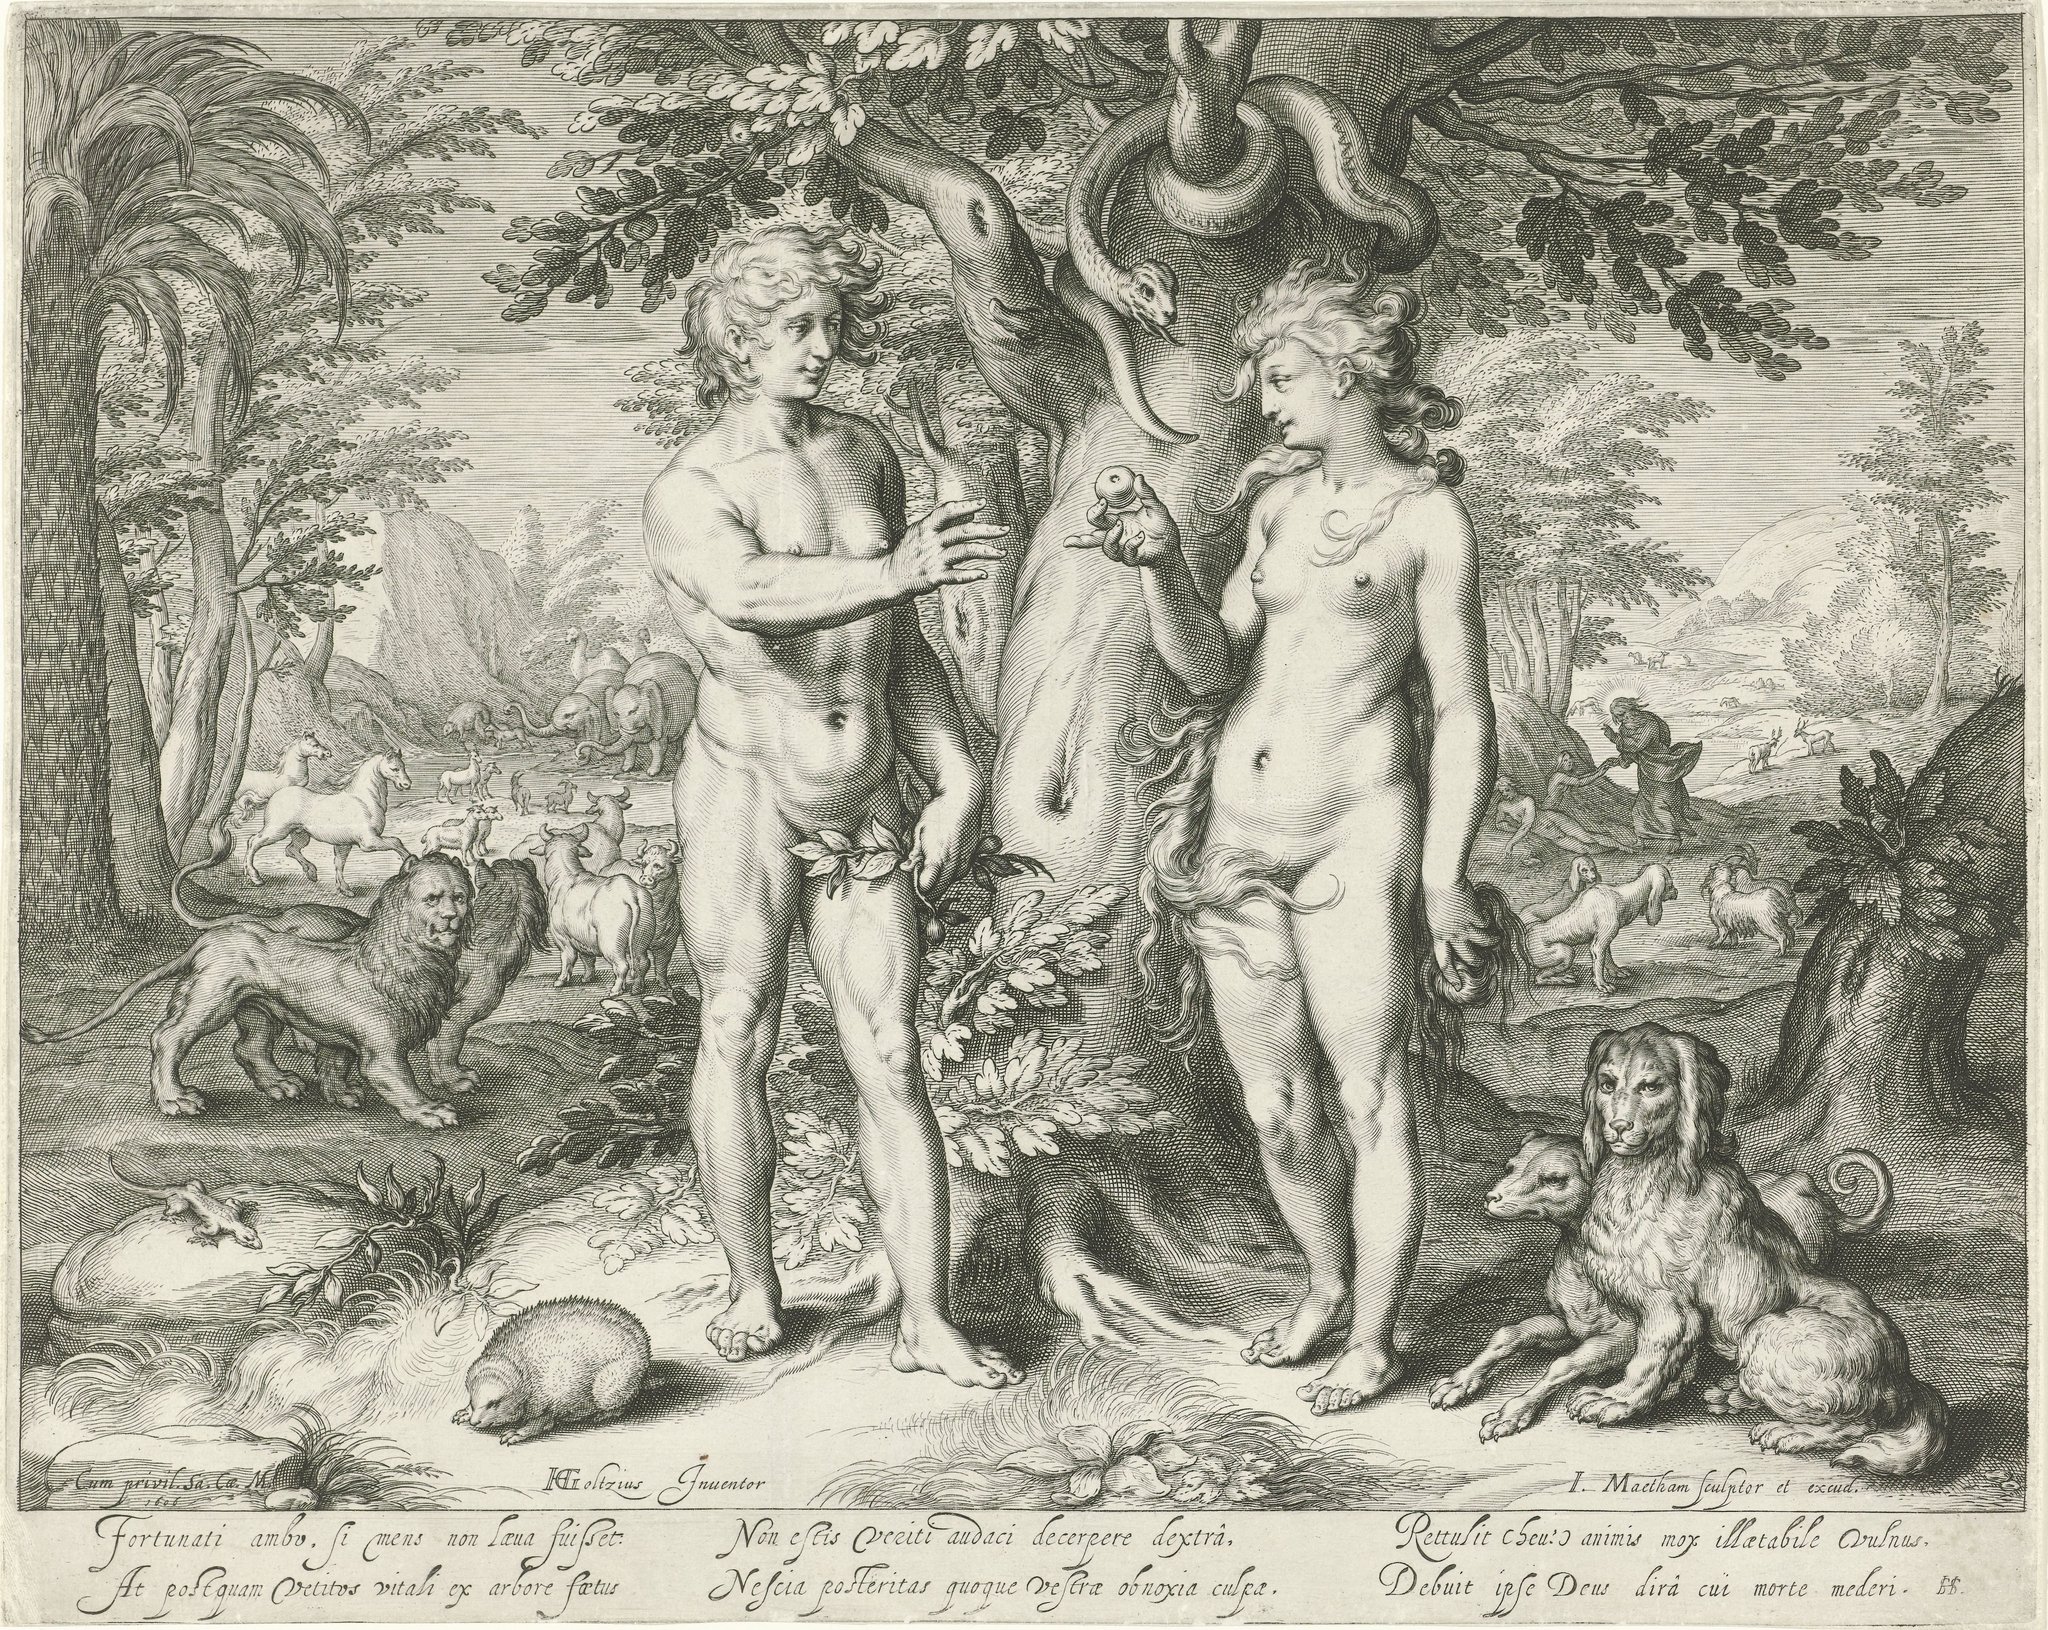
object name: print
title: Adam en Eva in het paradijs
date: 1606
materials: paper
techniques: engraving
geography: haarlem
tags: adam and eve in paradise (before the fall)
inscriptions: collector's mark: Lugt 240